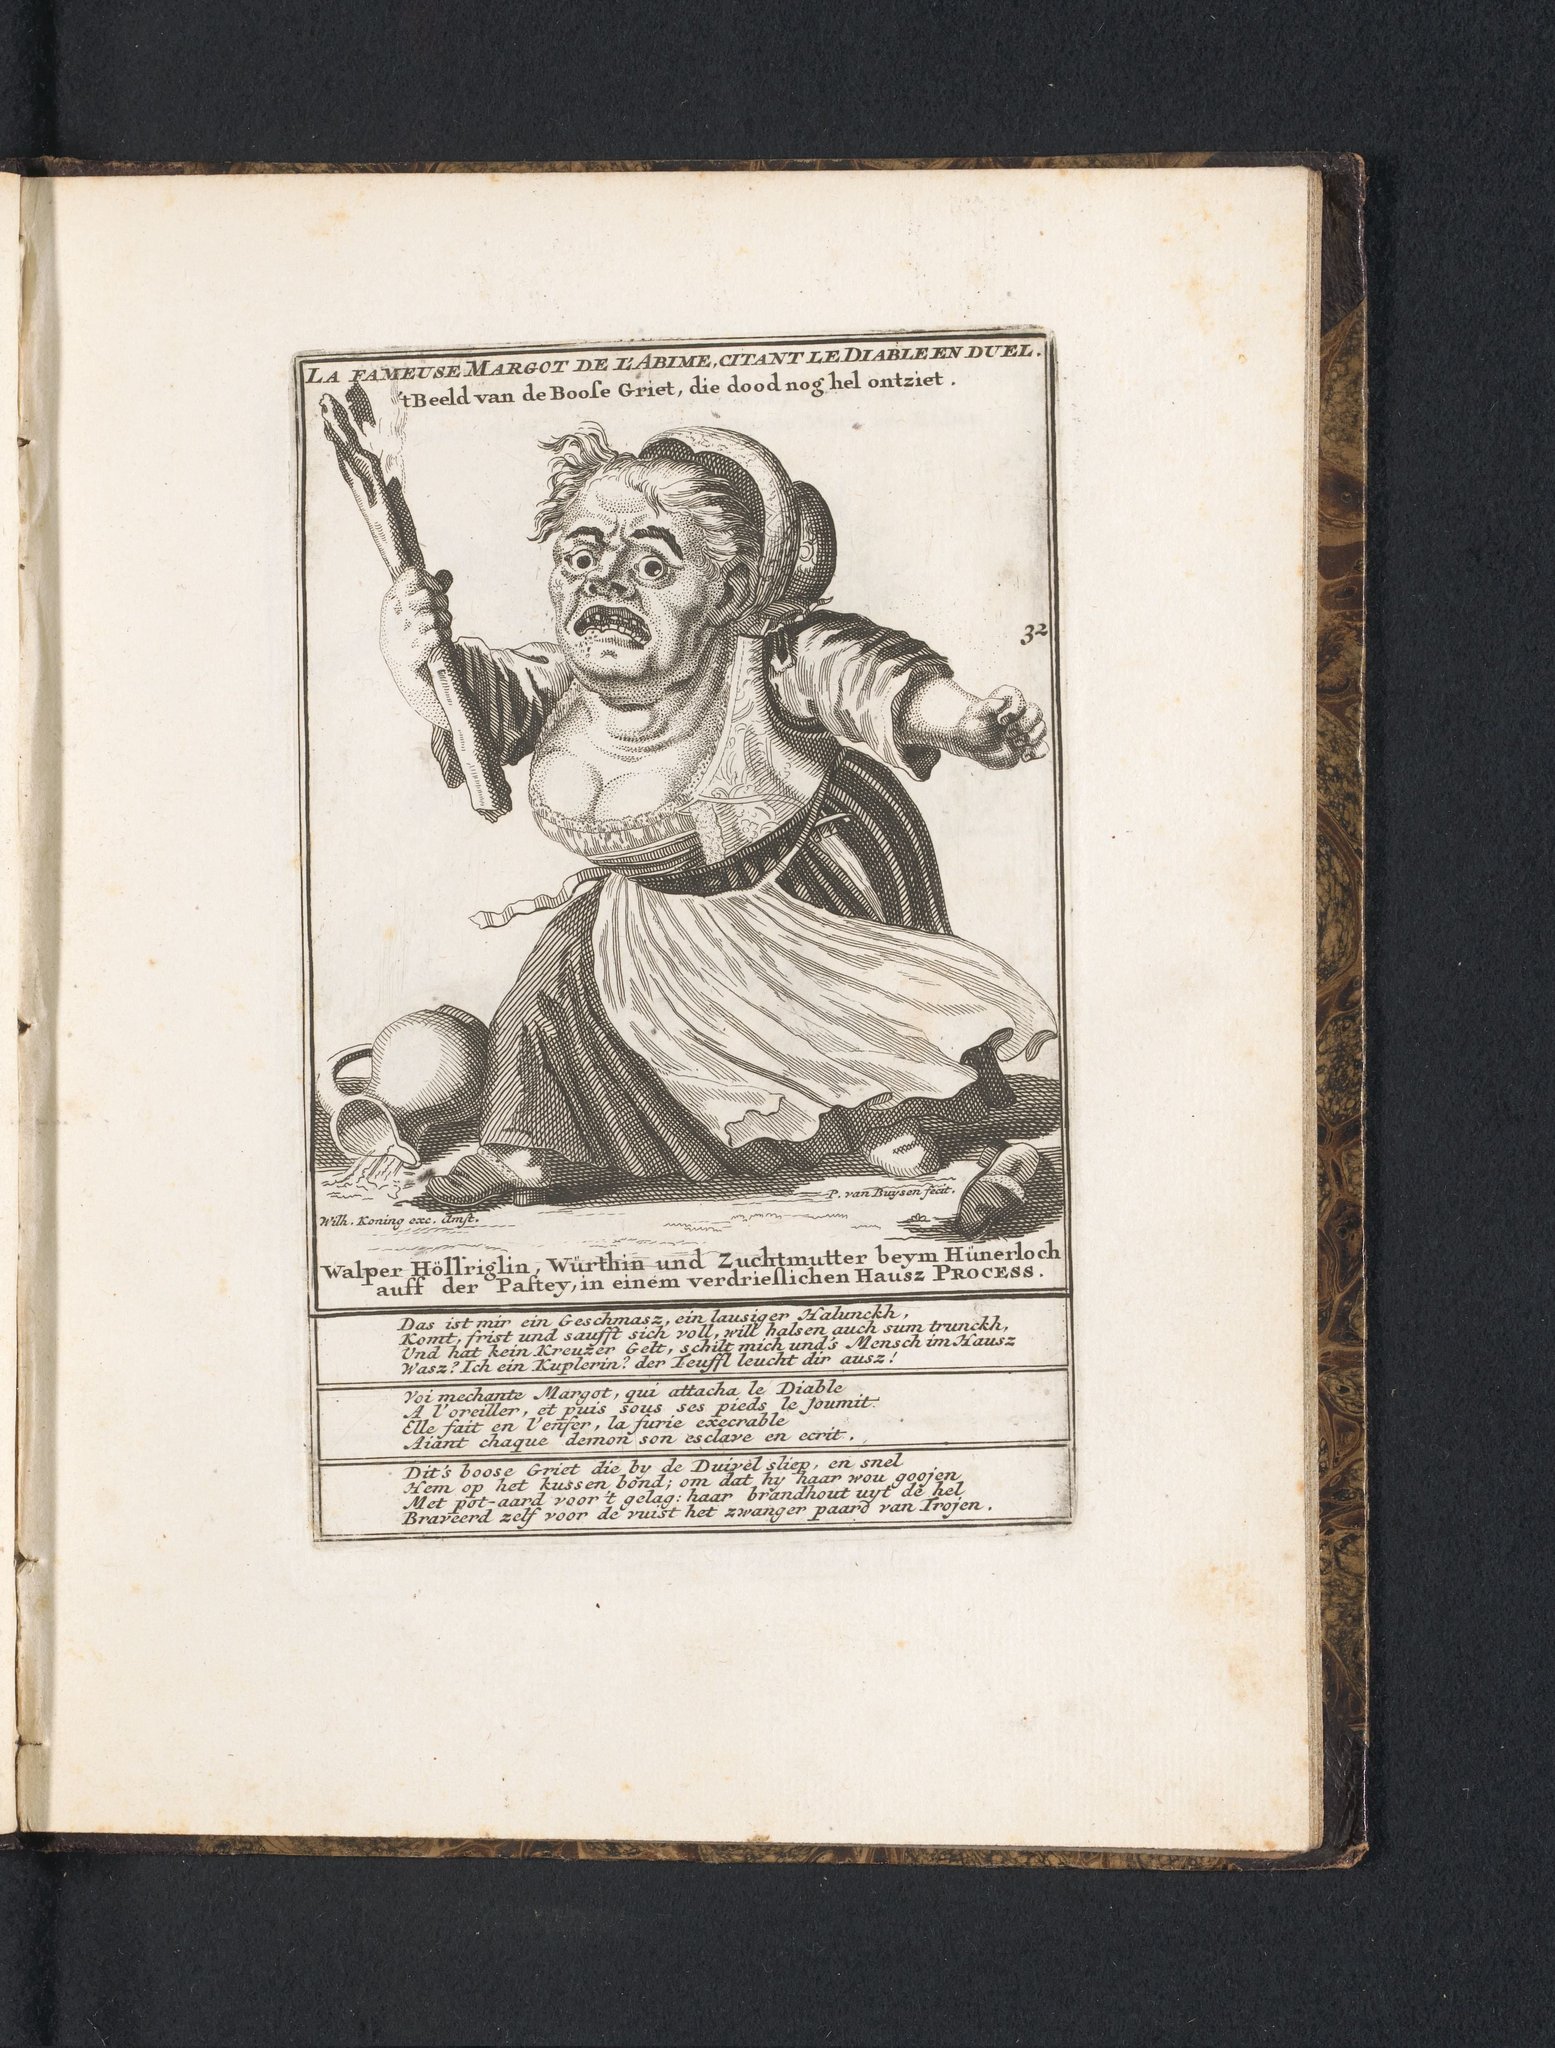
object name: print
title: De kleine mens Boose Griet als waardin, 1720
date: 1718-1720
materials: paper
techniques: etching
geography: amsterdam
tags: caricatures (human types), little people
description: De kleine mens Boose Griet als waardin met een brandend stuk hout. In het onderschrift verzen in het Duits, Frans en Nederlands. Genummerd rechts midden: 32. Onderdeel van deel II in de tweede Nederlandse gebonden uitgave uit 1720 (en gerelateerd aan de Windhandel in dat jaar) van een serie karikaturen van kleine mensen, bekend als Het Dwergentooneel.